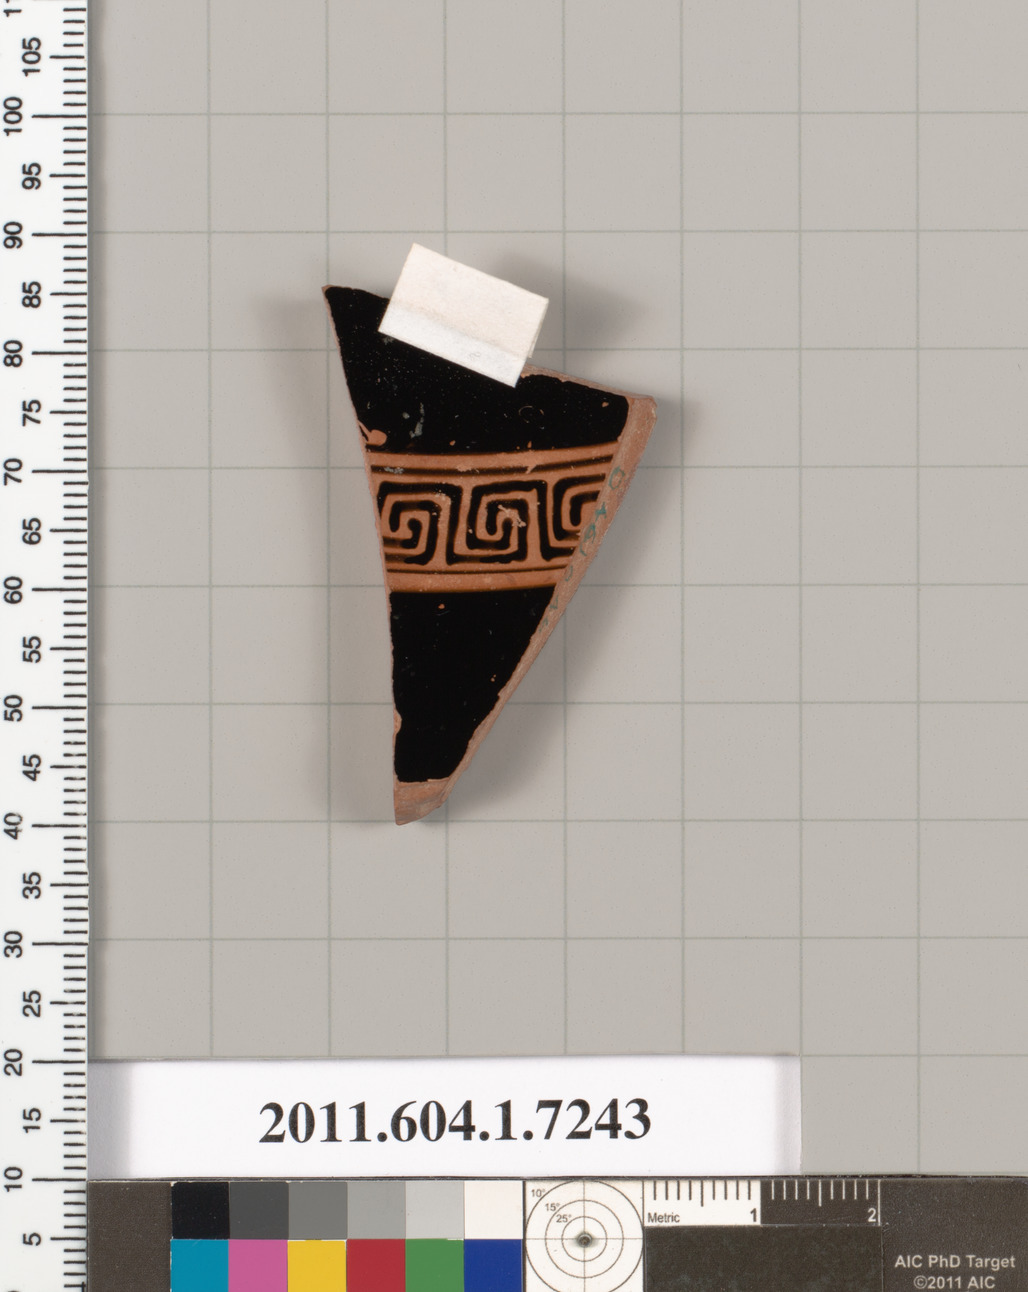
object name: kylix fragment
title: Terracotta fragment of a kylix (drinking cup)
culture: greek, attic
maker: makron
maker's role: artist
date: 500-480 BCE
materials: terracotta